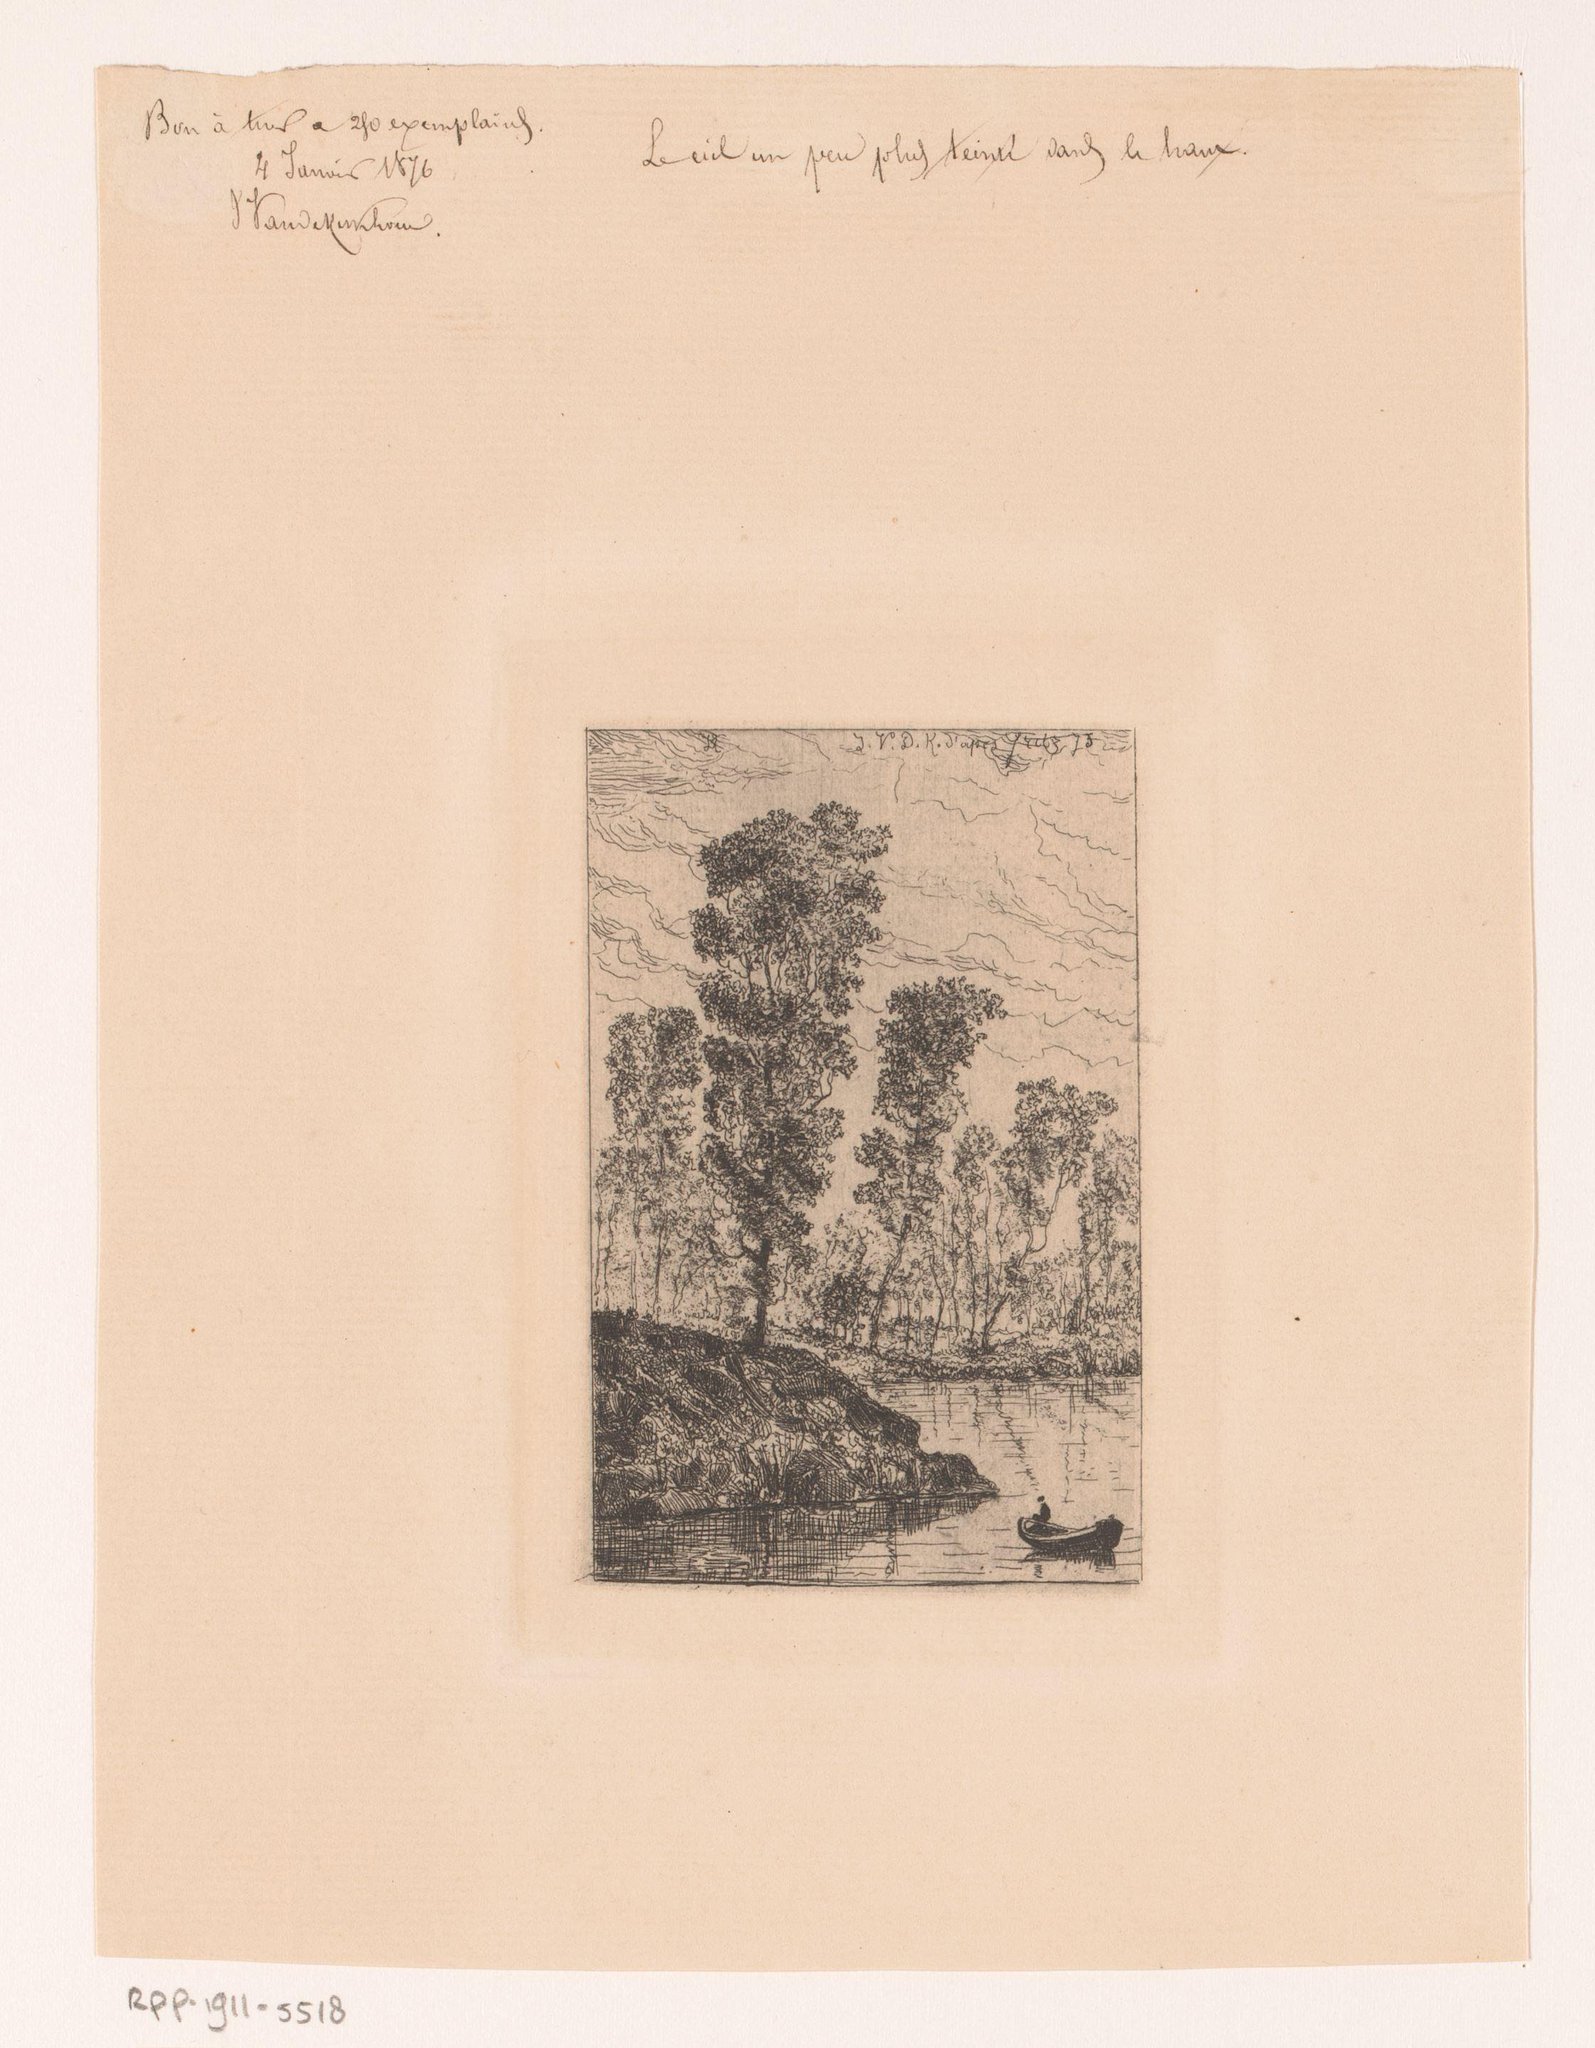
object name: print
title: Landschap met roeiboot op het water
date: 1873-1881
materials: paper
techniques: etching, intaglio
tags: water course, boat propelled by man or animal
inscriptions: collector's mark: Lugt 2228, inscription: ‘[...] 4 janvier 1876 J van de kerckhove [...]’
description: De etsen naar de schilderijen van Frédéric Van de Kerkhove werden na zijn dood door zijn vader en zuster gemaakt en uitgegeven in twee reeksen. De eerste werd in 1877 uitgegeven door het Journal des Beaux-Arts et de la Littérature: Cahier de 25 Eaux-fortes d'après Frédéric van de Kerkhove, gravées par son père et sa sœur. De tweede reeks van 126 etsen, ook in 1877, werd in Parijs uitgegeven bij A. Lévy onder de titel Cent eaux-fortes gravées par J. Van de Kerkhove d'après les tableaux de Frédéric Van de Kerkhove, mort en 1873 à l'âge de 10 ans et 11 mois.